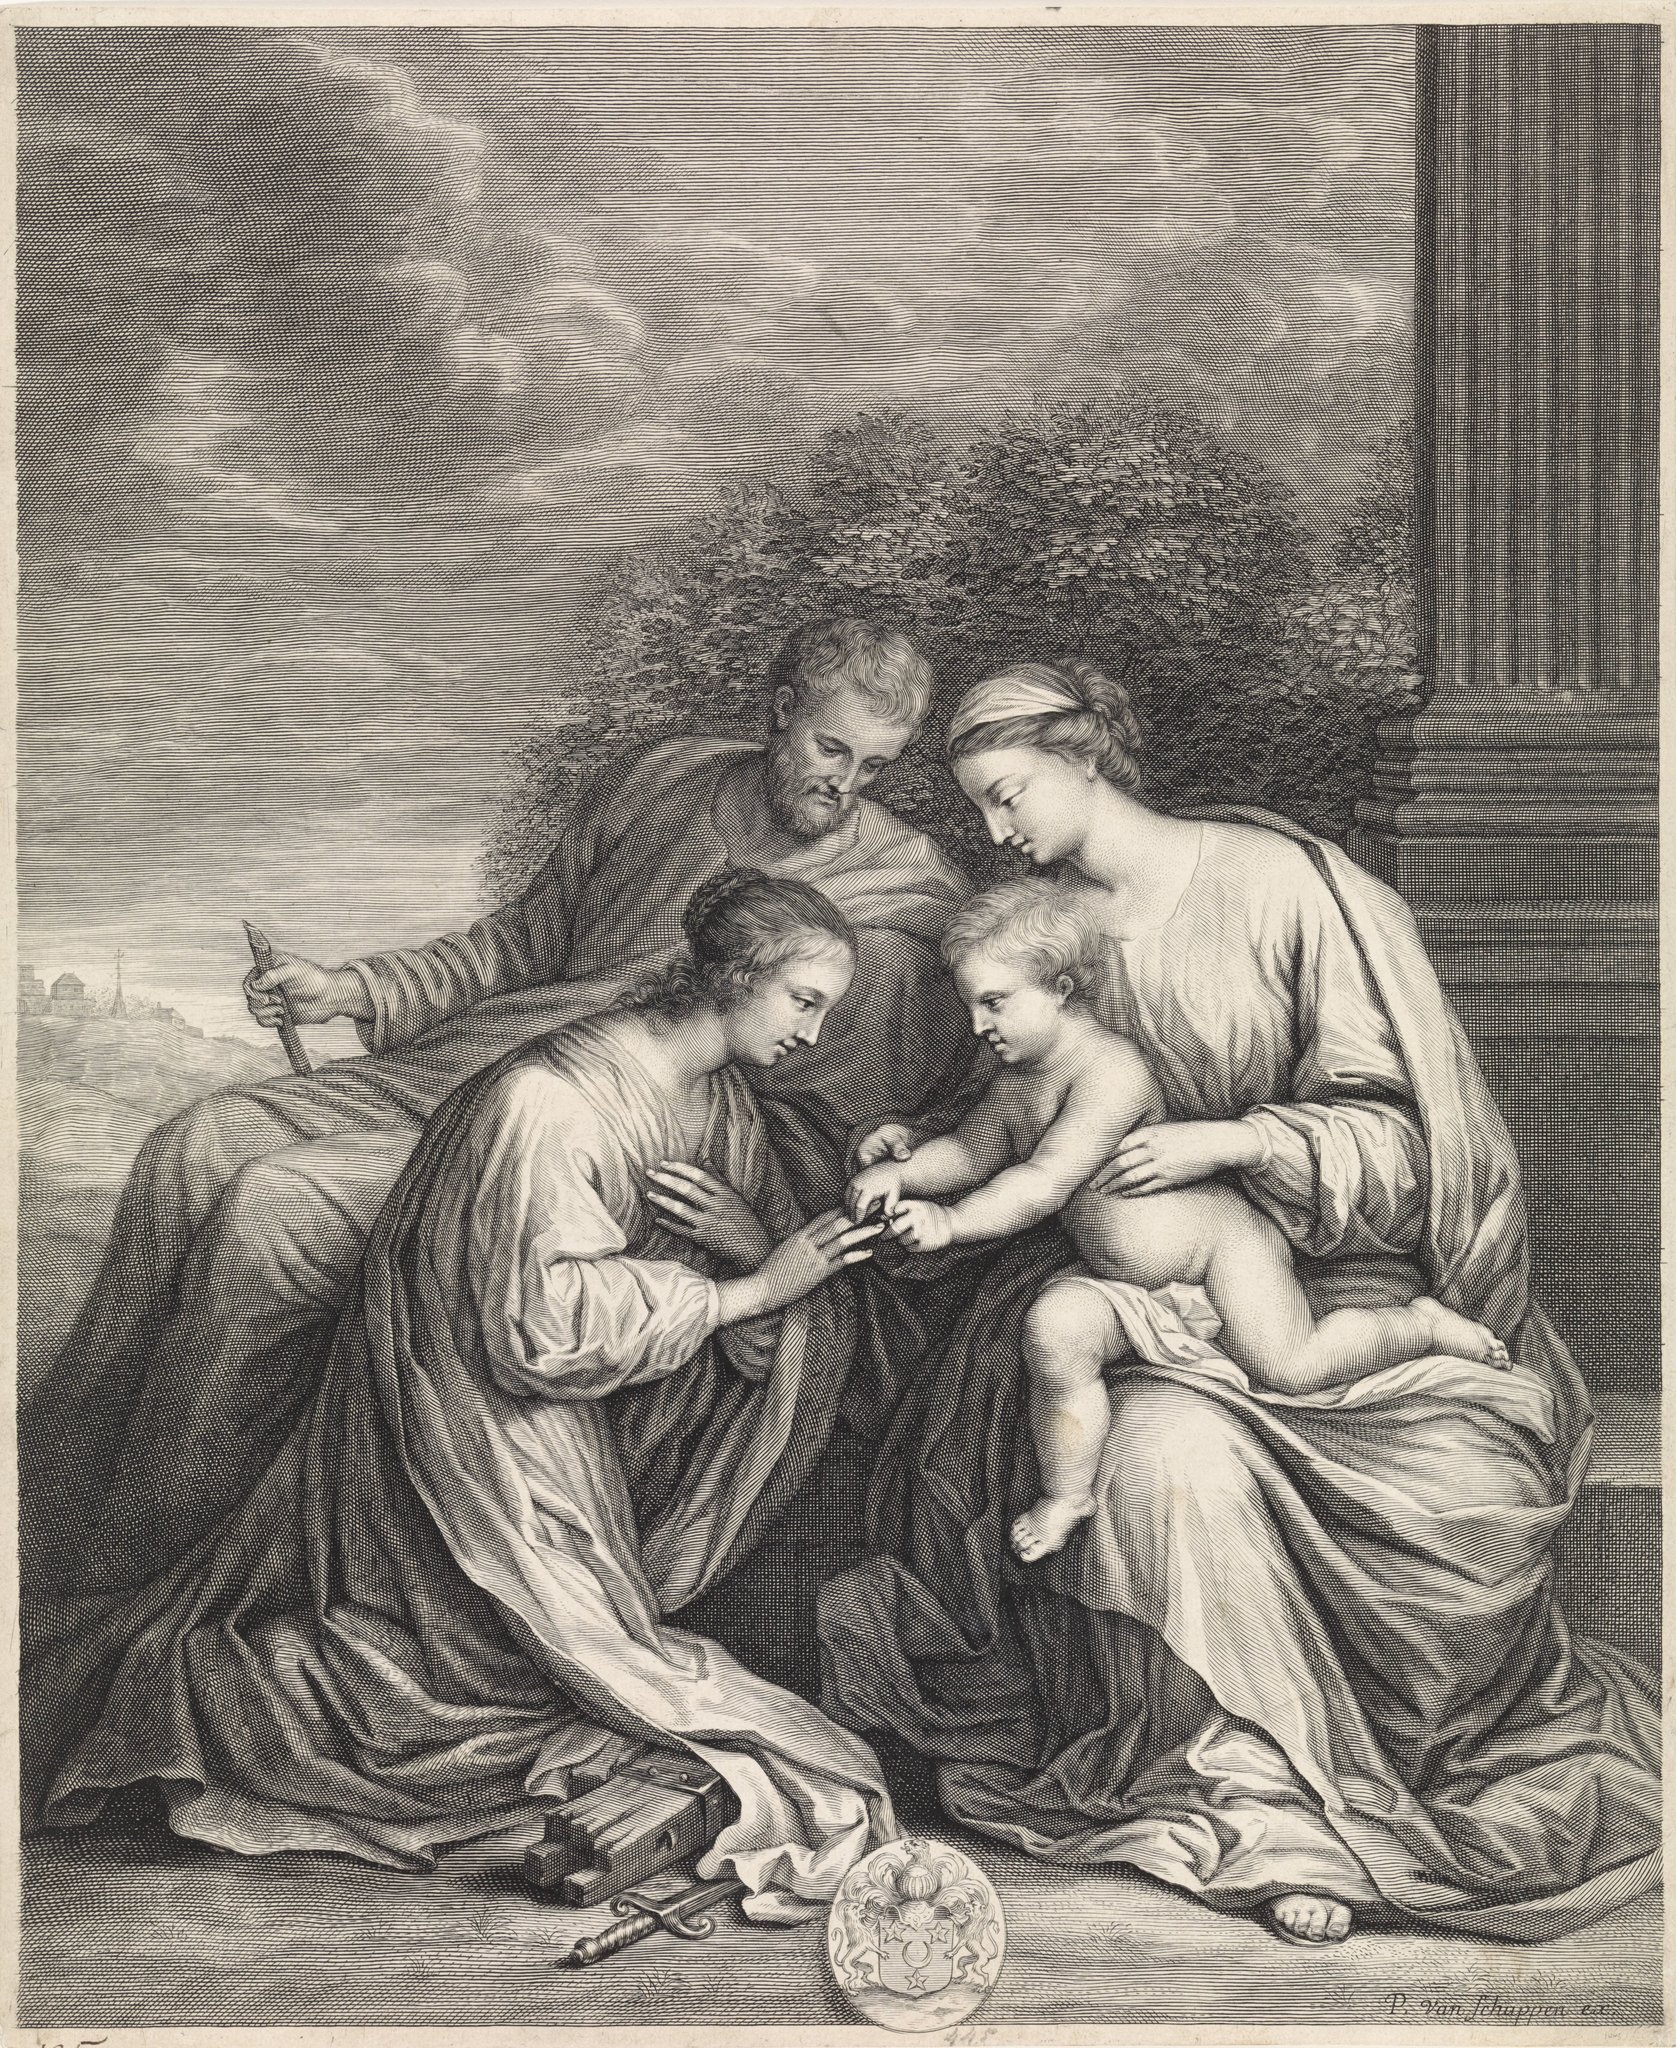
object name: print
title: Heilige familie met Catharina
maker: pieter van schuppen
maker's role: print maker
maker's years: 1627-1702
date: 1665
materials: paper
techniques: engraving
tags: holy family, and derived representations, the mystic marriage of st. catherine of alexandria with the infant christ: the christ-child puts a ring on her finger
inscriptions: collector's mark: Lugt 2228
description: Jozef en Maria kijken toe hoe het Christuskind vanaf de schoot van Maria een ring schuift aan de vinger van de heilige Catharina van Alexandrië. Op de grond liggen Catharina's vaste attributen: een zwaard en een stuk van een wiel met ijzeren spijkers. Onderaan een wapenschild met een halve maan en drie sterren.